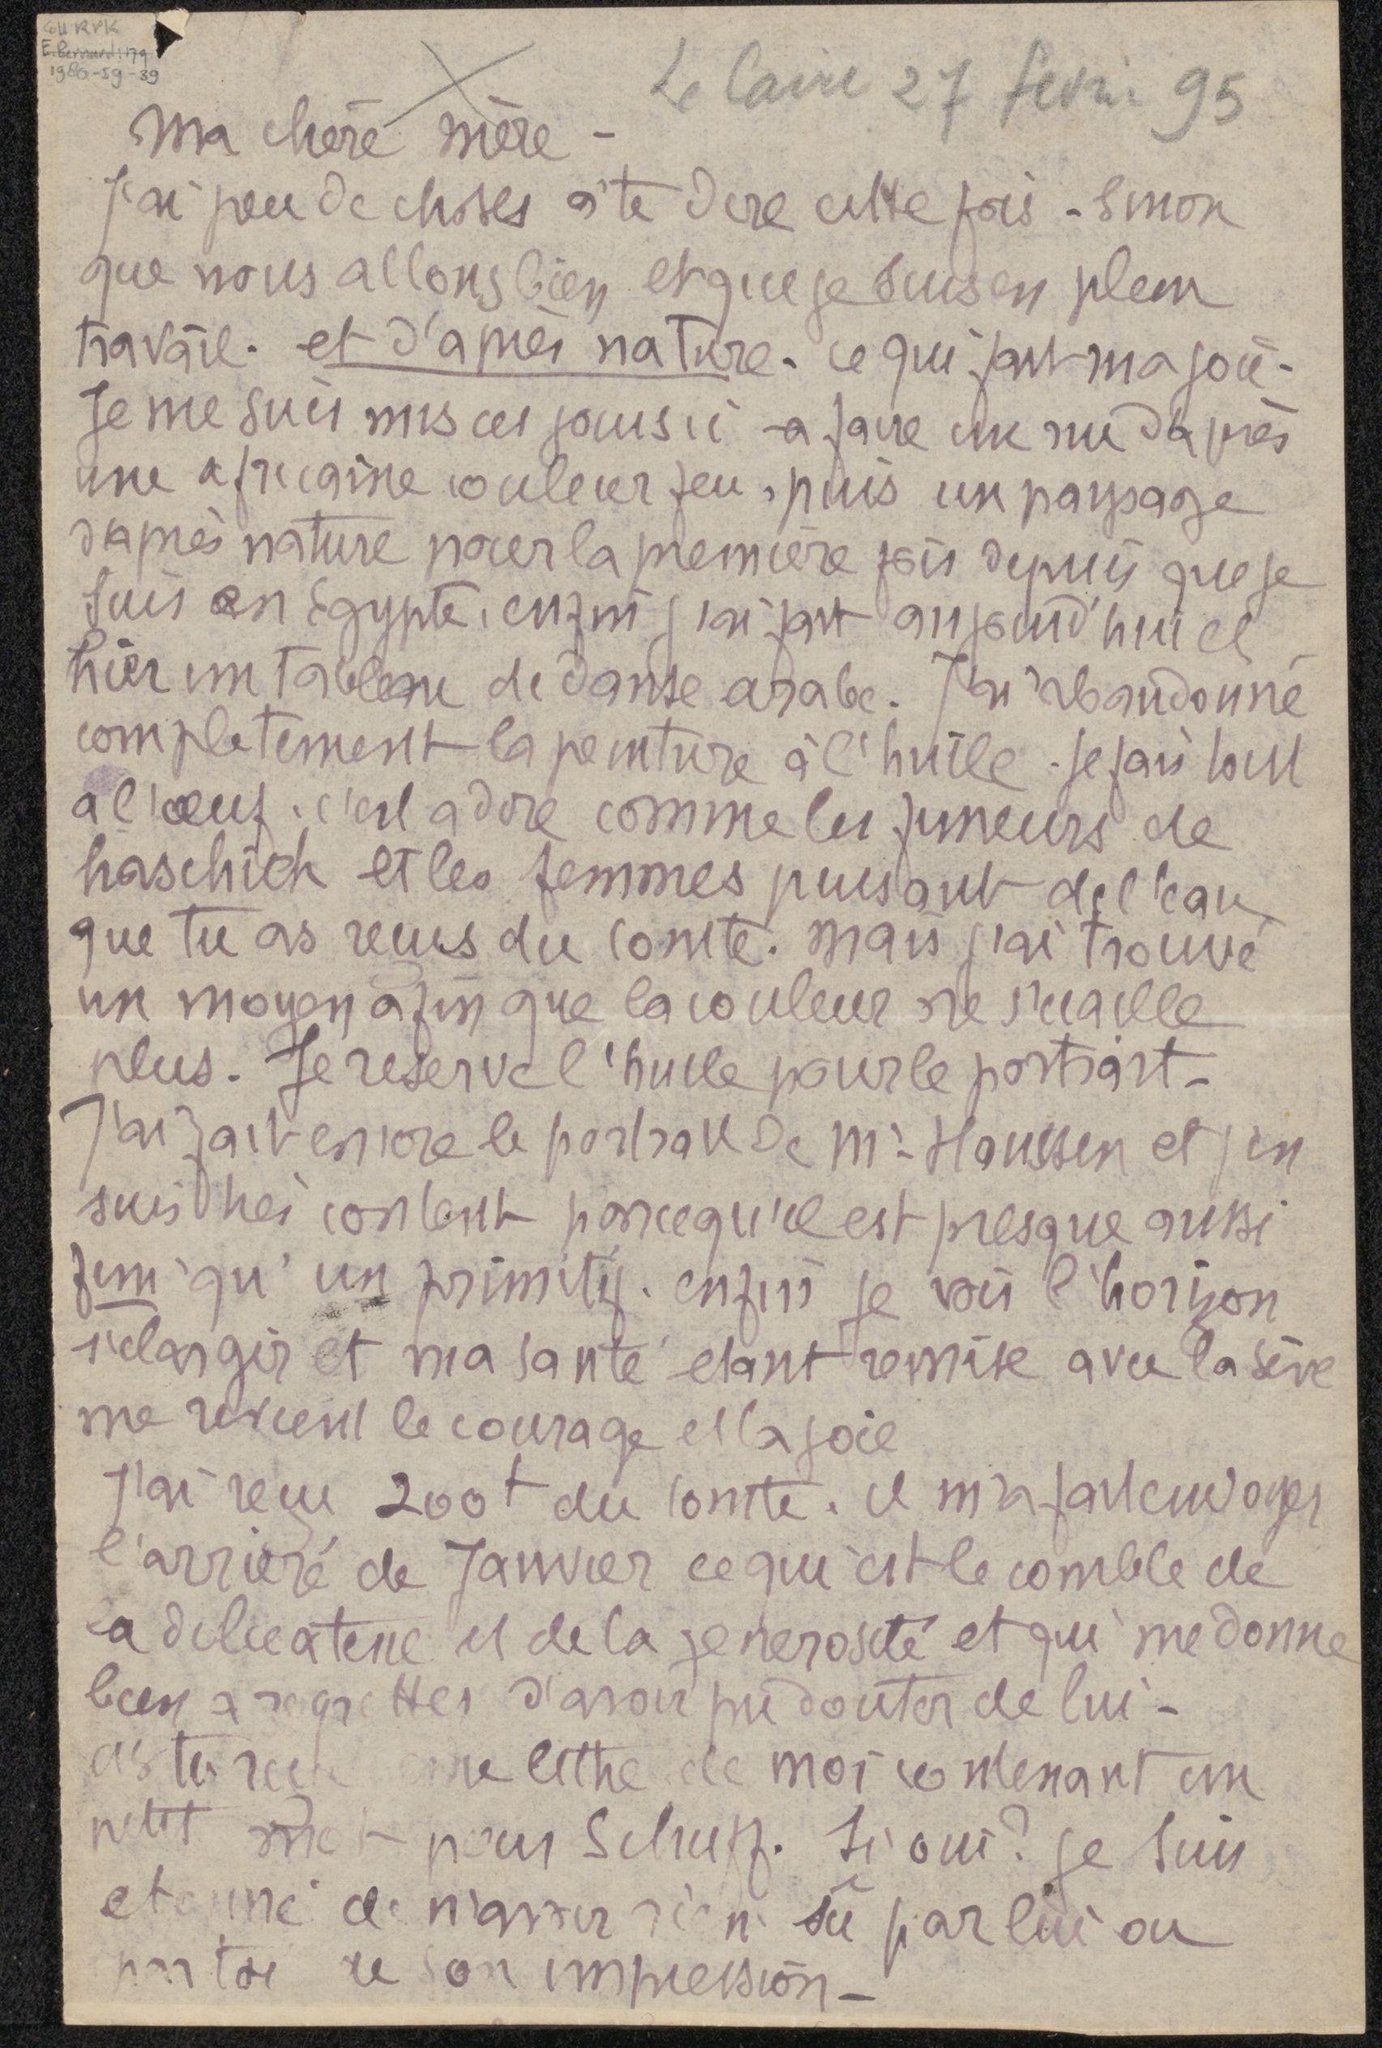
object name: letter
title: Brief aan Héloïse Bernard-Bodin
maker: émile bernard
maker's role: print maker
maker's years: 1868-1941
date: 1894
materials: ink, paper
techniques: pen, writing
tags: héloïse bernard-bodin